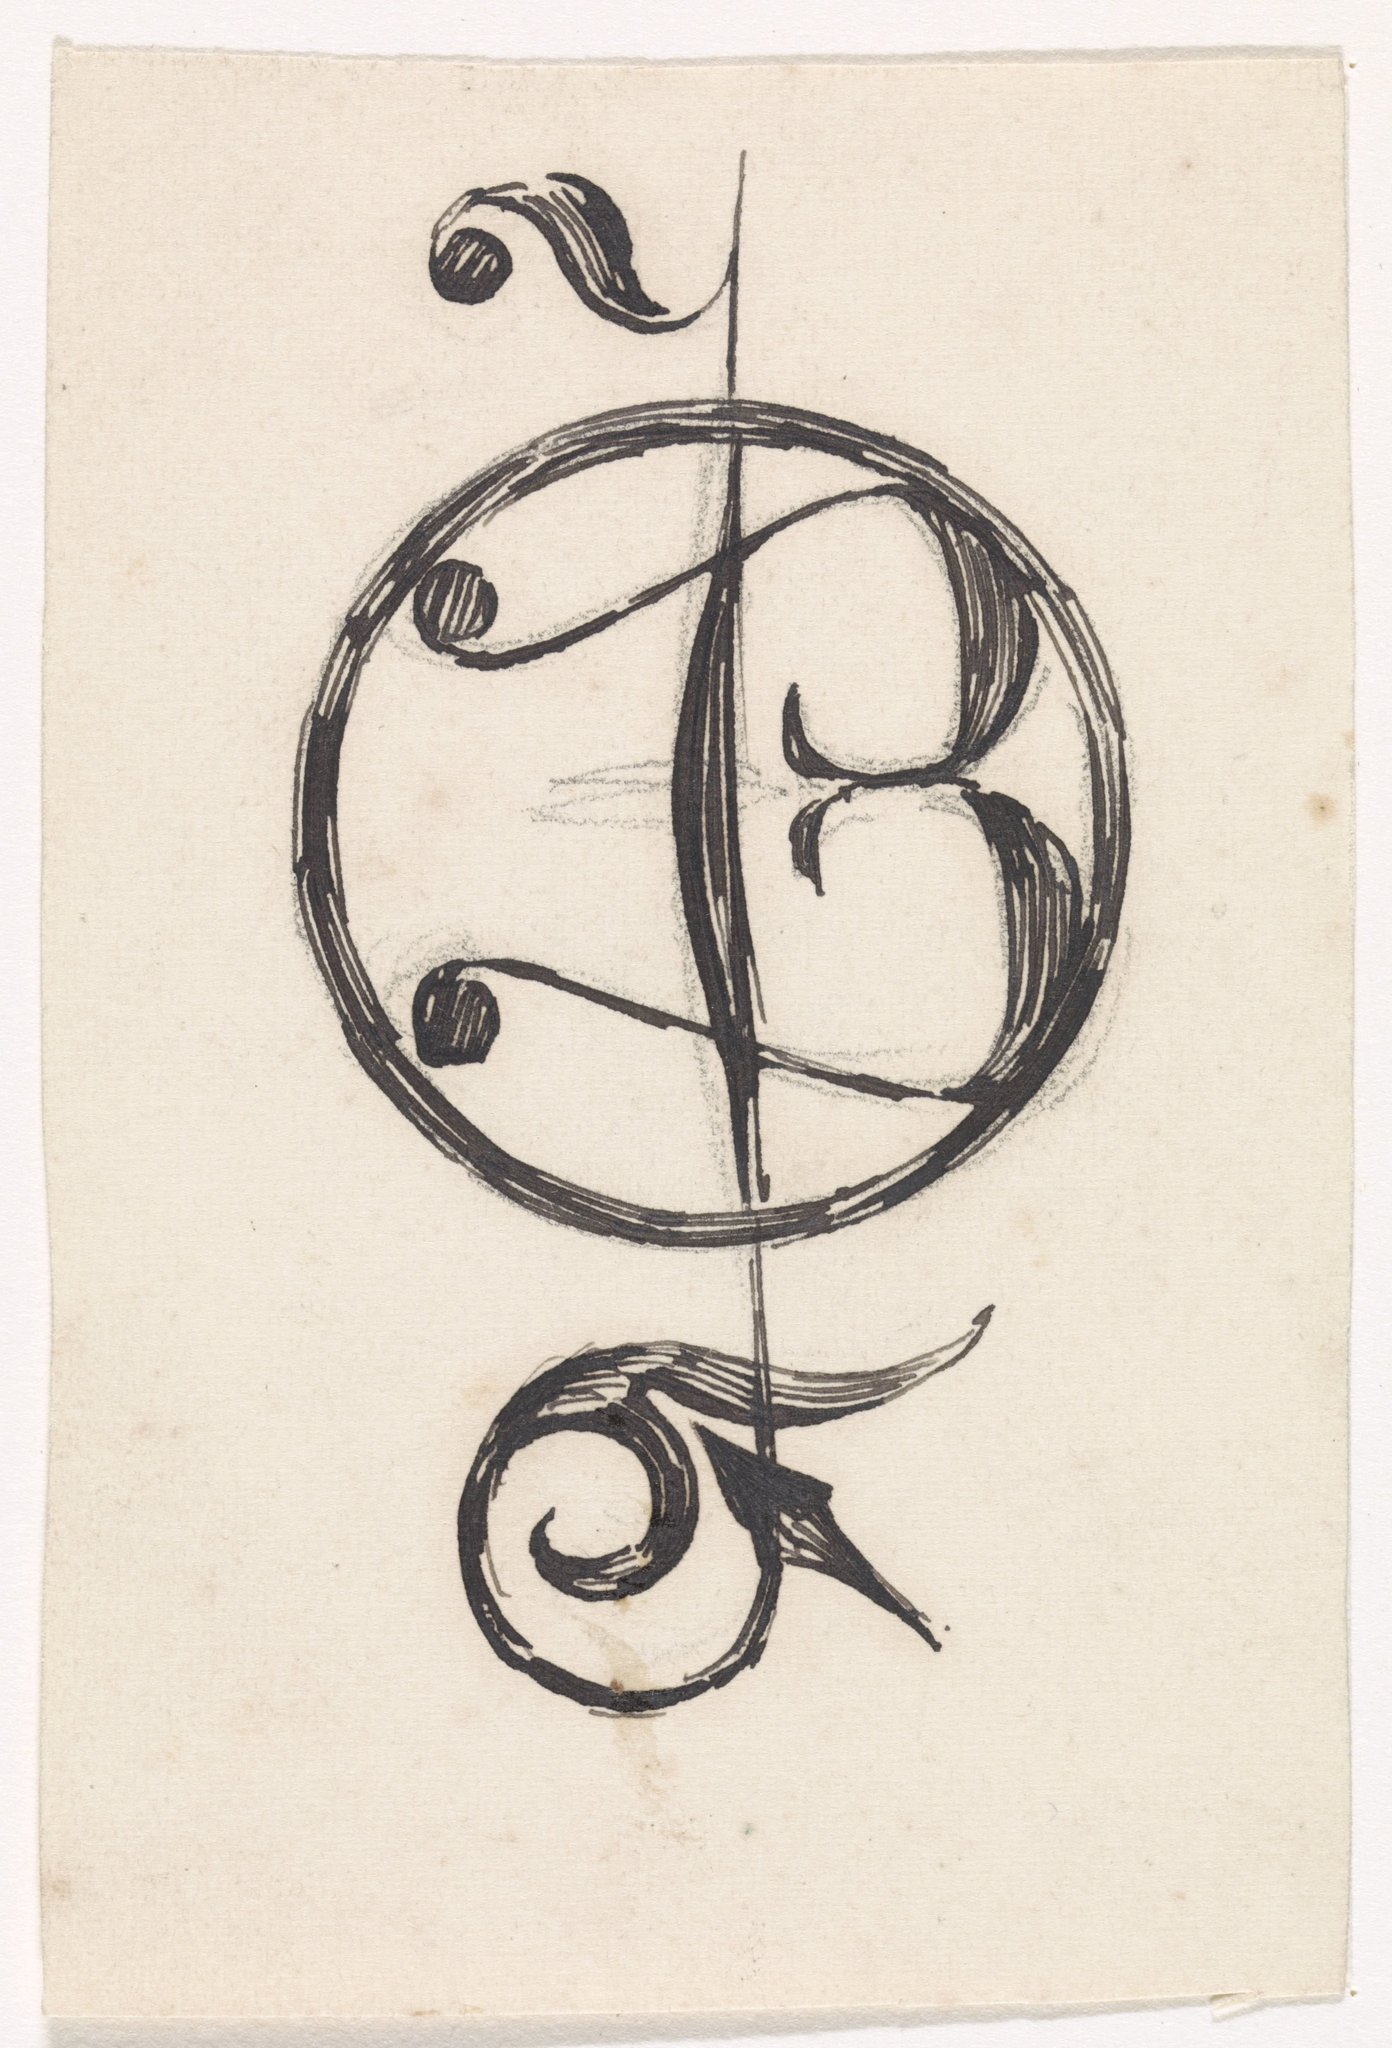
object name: drawing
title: Ontwerp voor een monogram met de letters J en B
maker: antoon derkinderen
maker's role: draughtsman, painter, print maker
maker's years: 1859-1925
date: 1869-1925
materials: ink, paper, pencil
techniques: pen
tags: letter combinations such as letterword, anagram, letter square, monogram, etc.